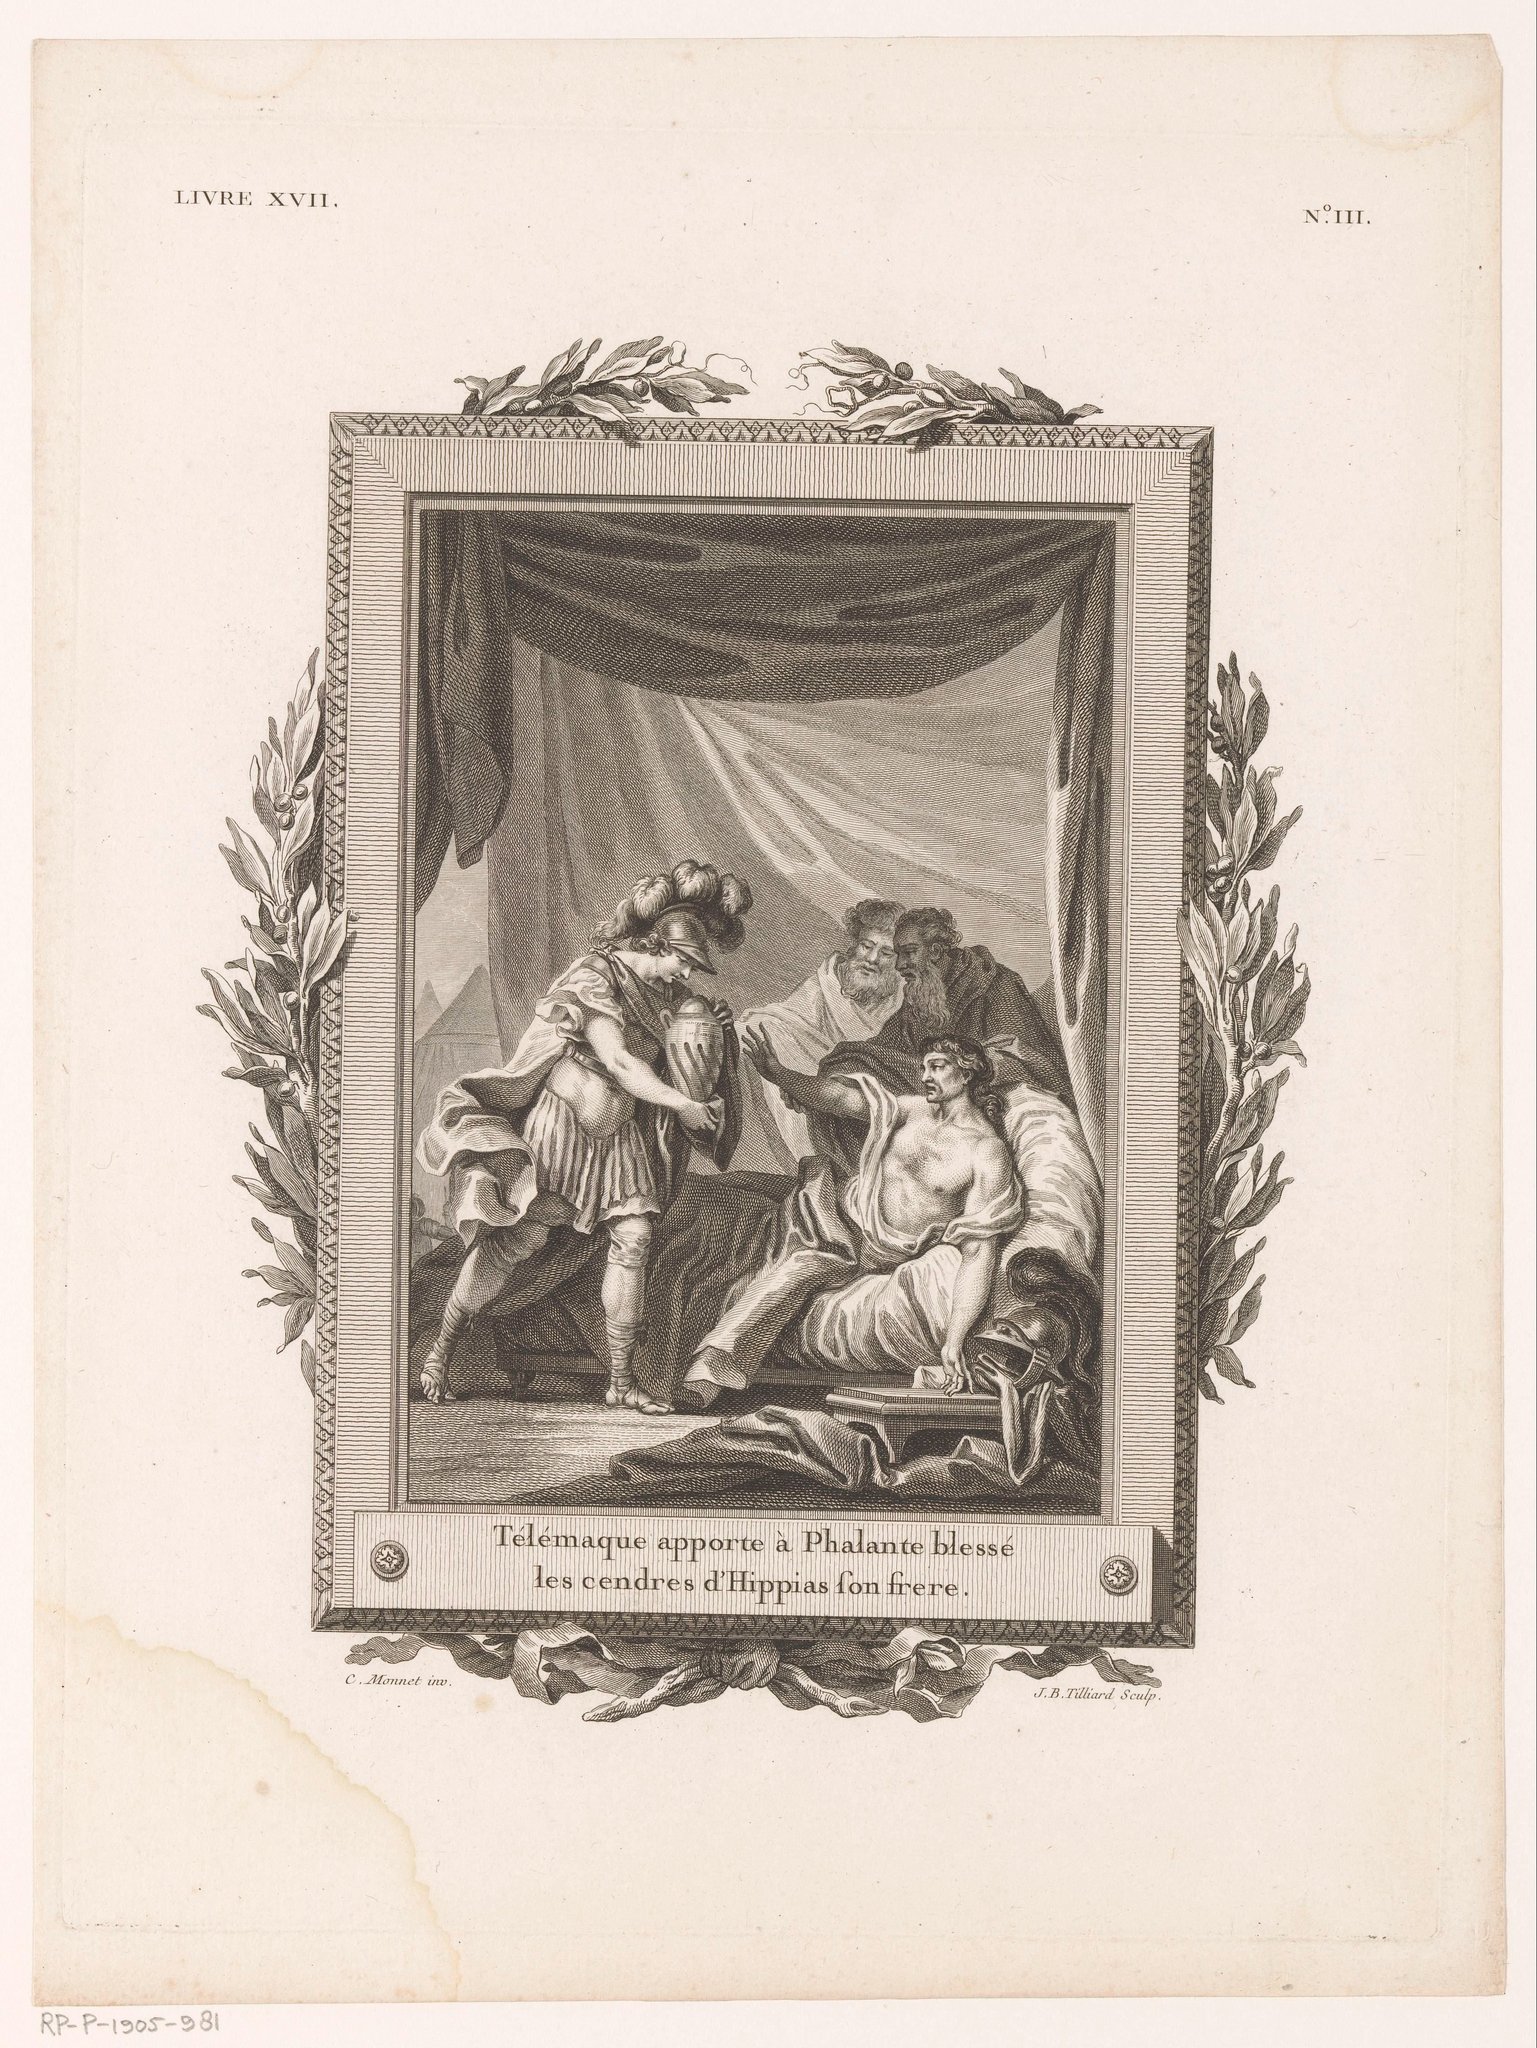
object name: book illustration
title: Telemachus brengt de as van Hippias naar Phalantus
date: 1785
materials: paper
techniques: engraving, etching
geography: paris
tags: (fenelon, telemachus) specific works of literature (with author, title), urn, (story of) telemachus, ornament ~ festoon, garland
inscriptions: collector's mark: Lugt 2228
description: Telemachus brengt de gewonde Phalantus, gelegen in een bed in een tent, de as van zijn overleden broer Hippias. Telemachus, aan de linkerzijde, draagt de urn in zijn handen. Op de achtergrond is een tentenkamp zichtbaar. Het geheel wordt gekaderd door een sierlijst met olijftakken en onderaan een strik. Genummerd rechtsboven: No. III.